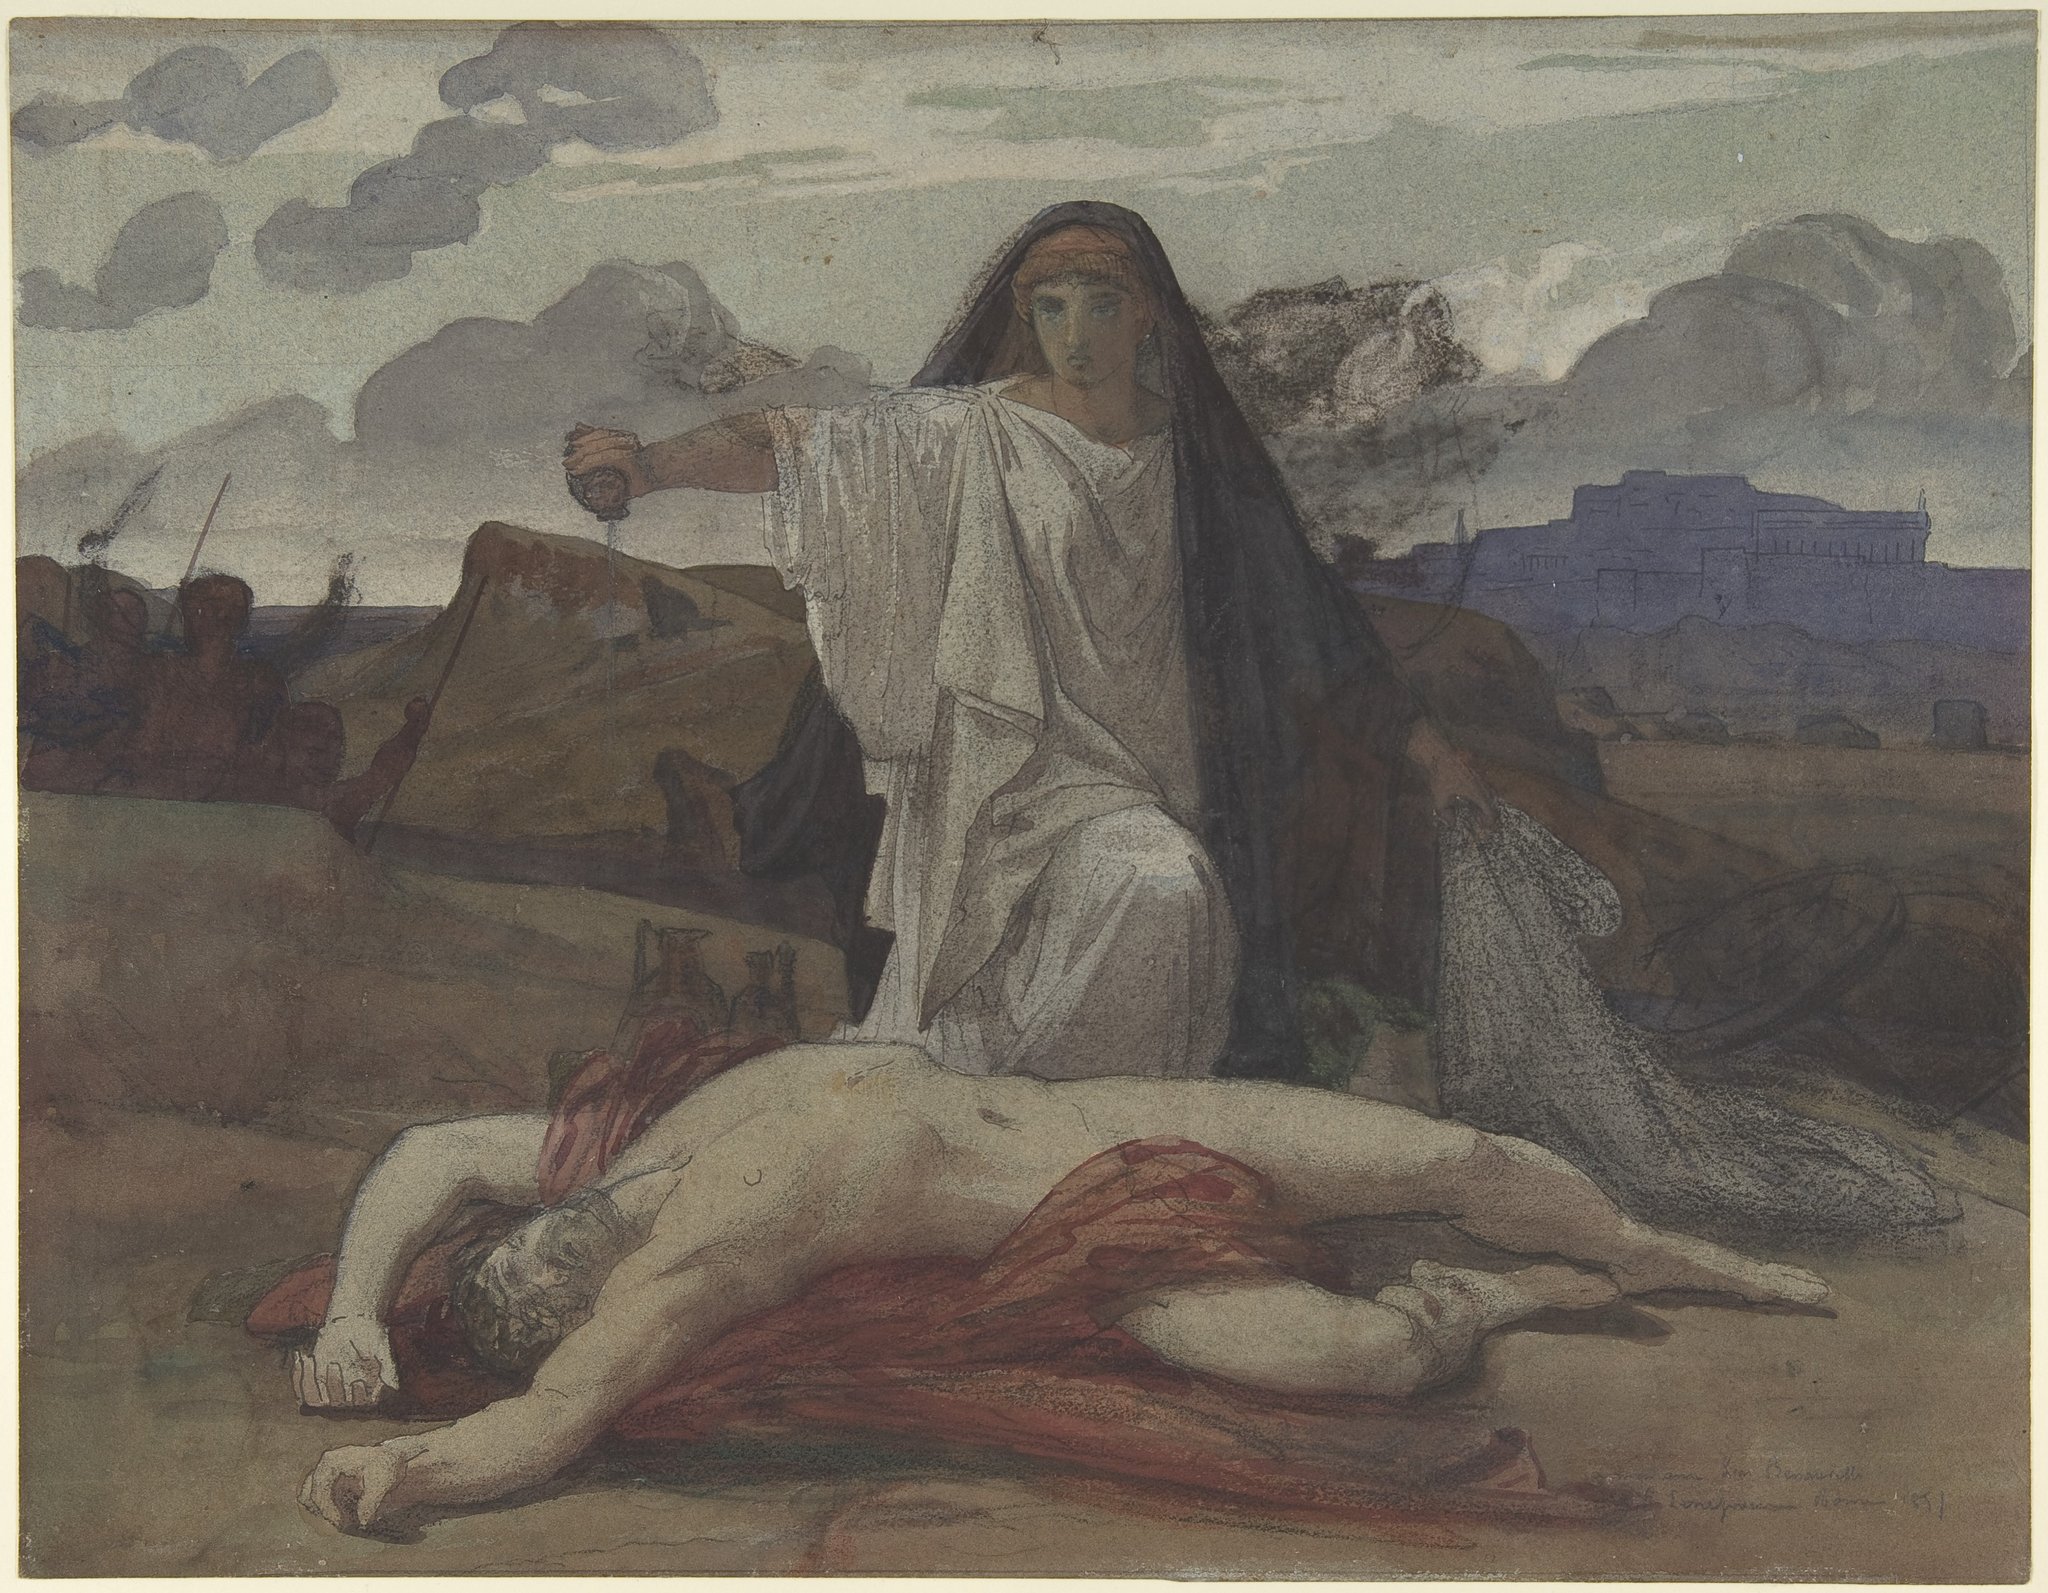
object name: drawing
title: Antigone Gives Token Burial to the Body of Her Brother Polynices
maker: jules-eugène lenepveu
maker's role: artist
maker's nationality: french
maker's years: 1819-1898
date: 1835-1898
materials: chalk, ink, paper, watercolor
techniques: pen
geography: france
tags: men,women,burials,death